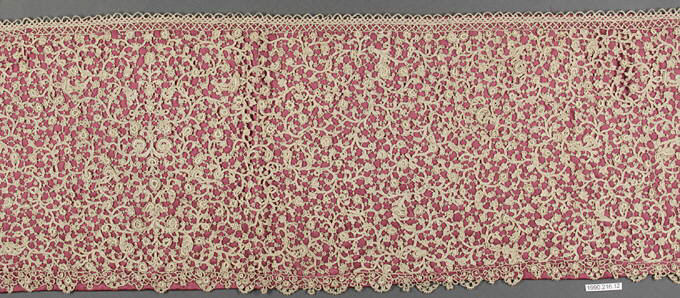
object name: border or flounce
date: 1601-1700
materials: linen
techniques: lace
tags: flowers